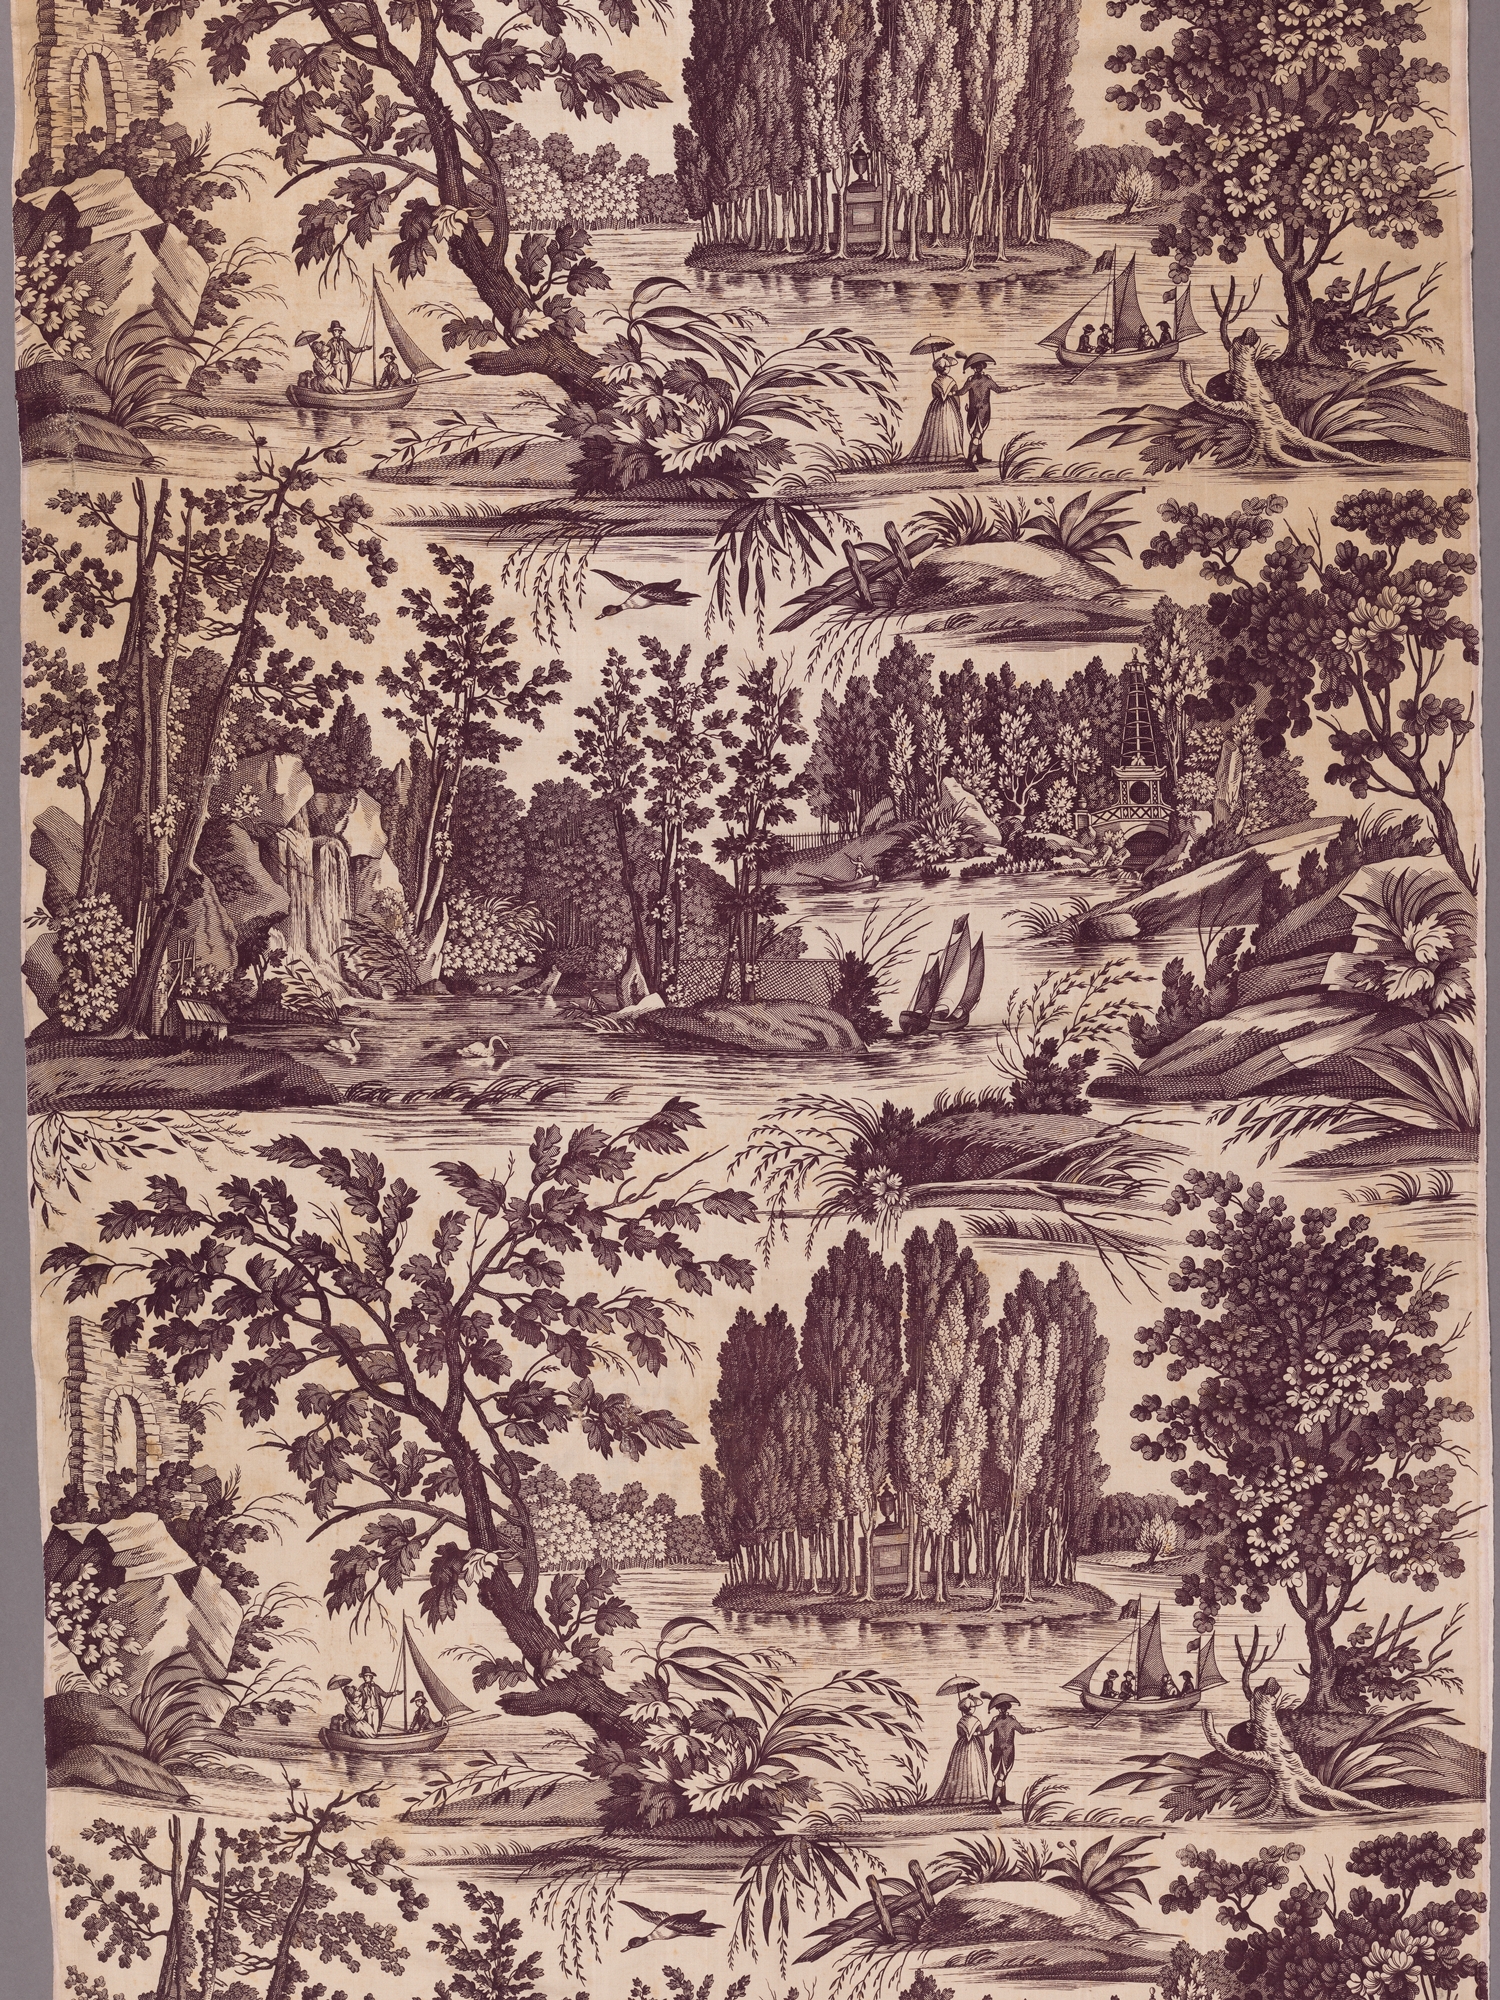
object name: piece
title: "Tomb of Rousseau"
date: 1800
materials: cotton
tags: tombs,landscapes,leaves,trees,boats